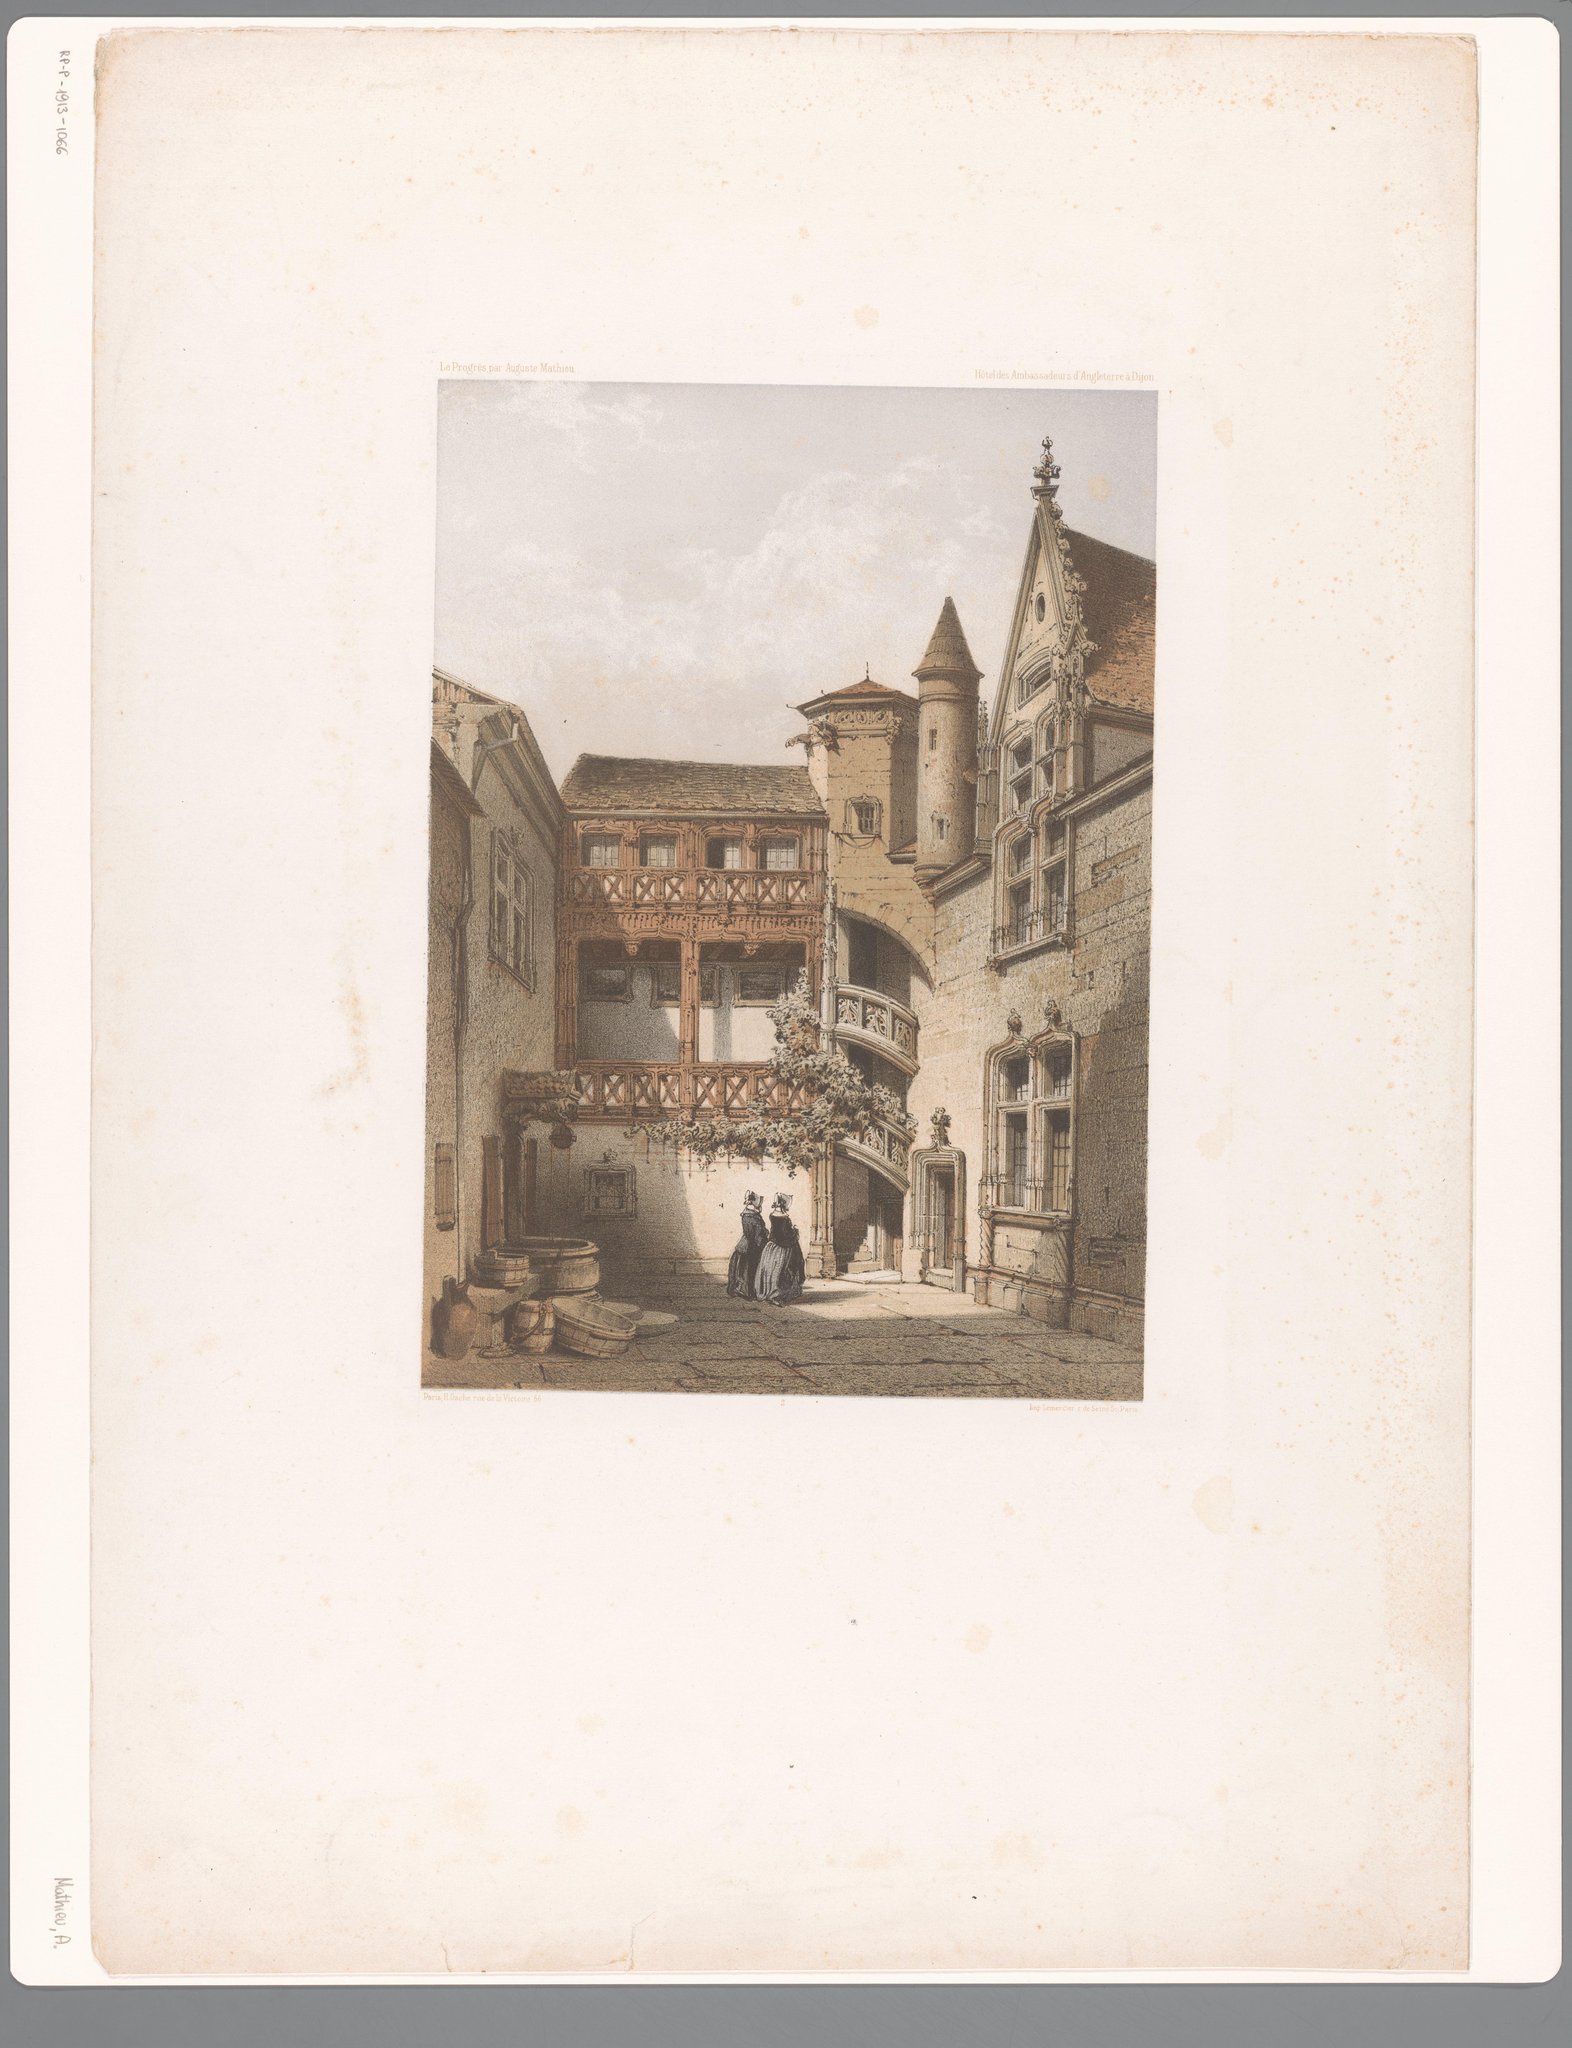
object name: print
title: Huis van de Engelse gezanten in Dijon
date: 1850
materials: paper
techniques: lithograph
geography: paris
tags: ambassador, façade (of house or building)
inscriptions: collector's mark: Lugt 2228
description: Prent is deel van de bij Gache uitgegeven twaalfdelige lithoserie: Le progrès. Souvenirs de France et de l'Allemagne.